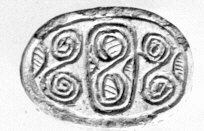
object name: stamp seal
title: Scarab seal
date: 1700-1560 BCE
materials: stone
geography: levant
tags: scarabs